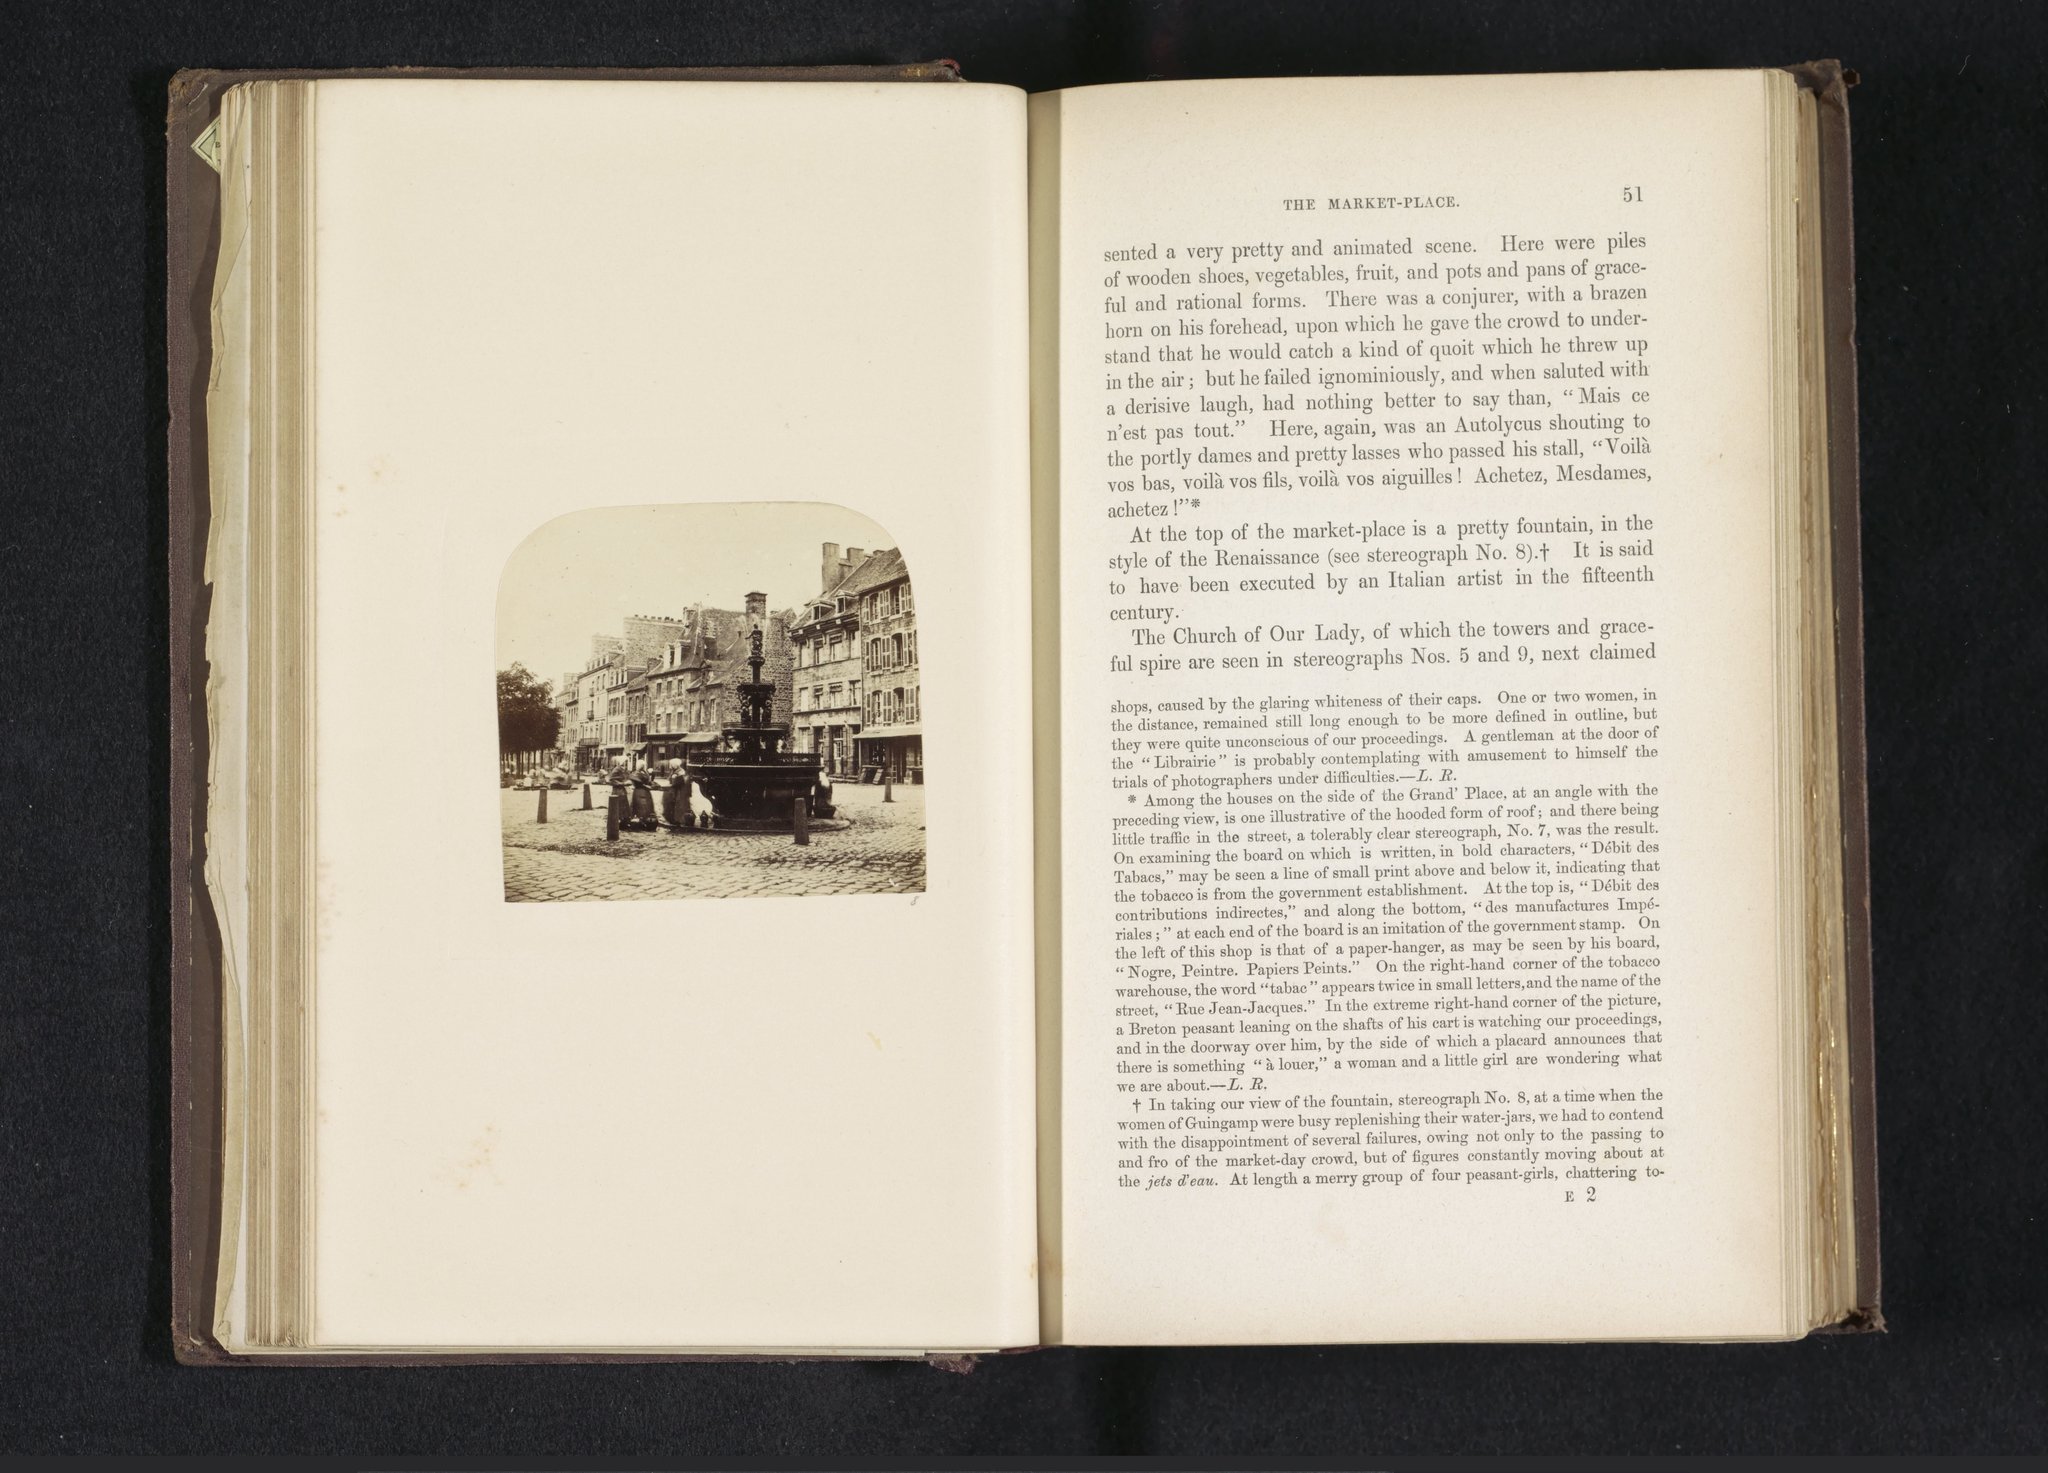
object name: photograph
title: Boerinnen bij een fontein op de Grande Place te Guincamp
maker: taylor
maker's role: fotograaf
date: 1850-1859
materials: photographic support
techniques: albumen print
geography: guingamp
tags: farmers - aa - female farmer, farmer's wife, ornamental fountain (+ city(-scape) with figures, staffage)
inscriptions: number: ‘8’